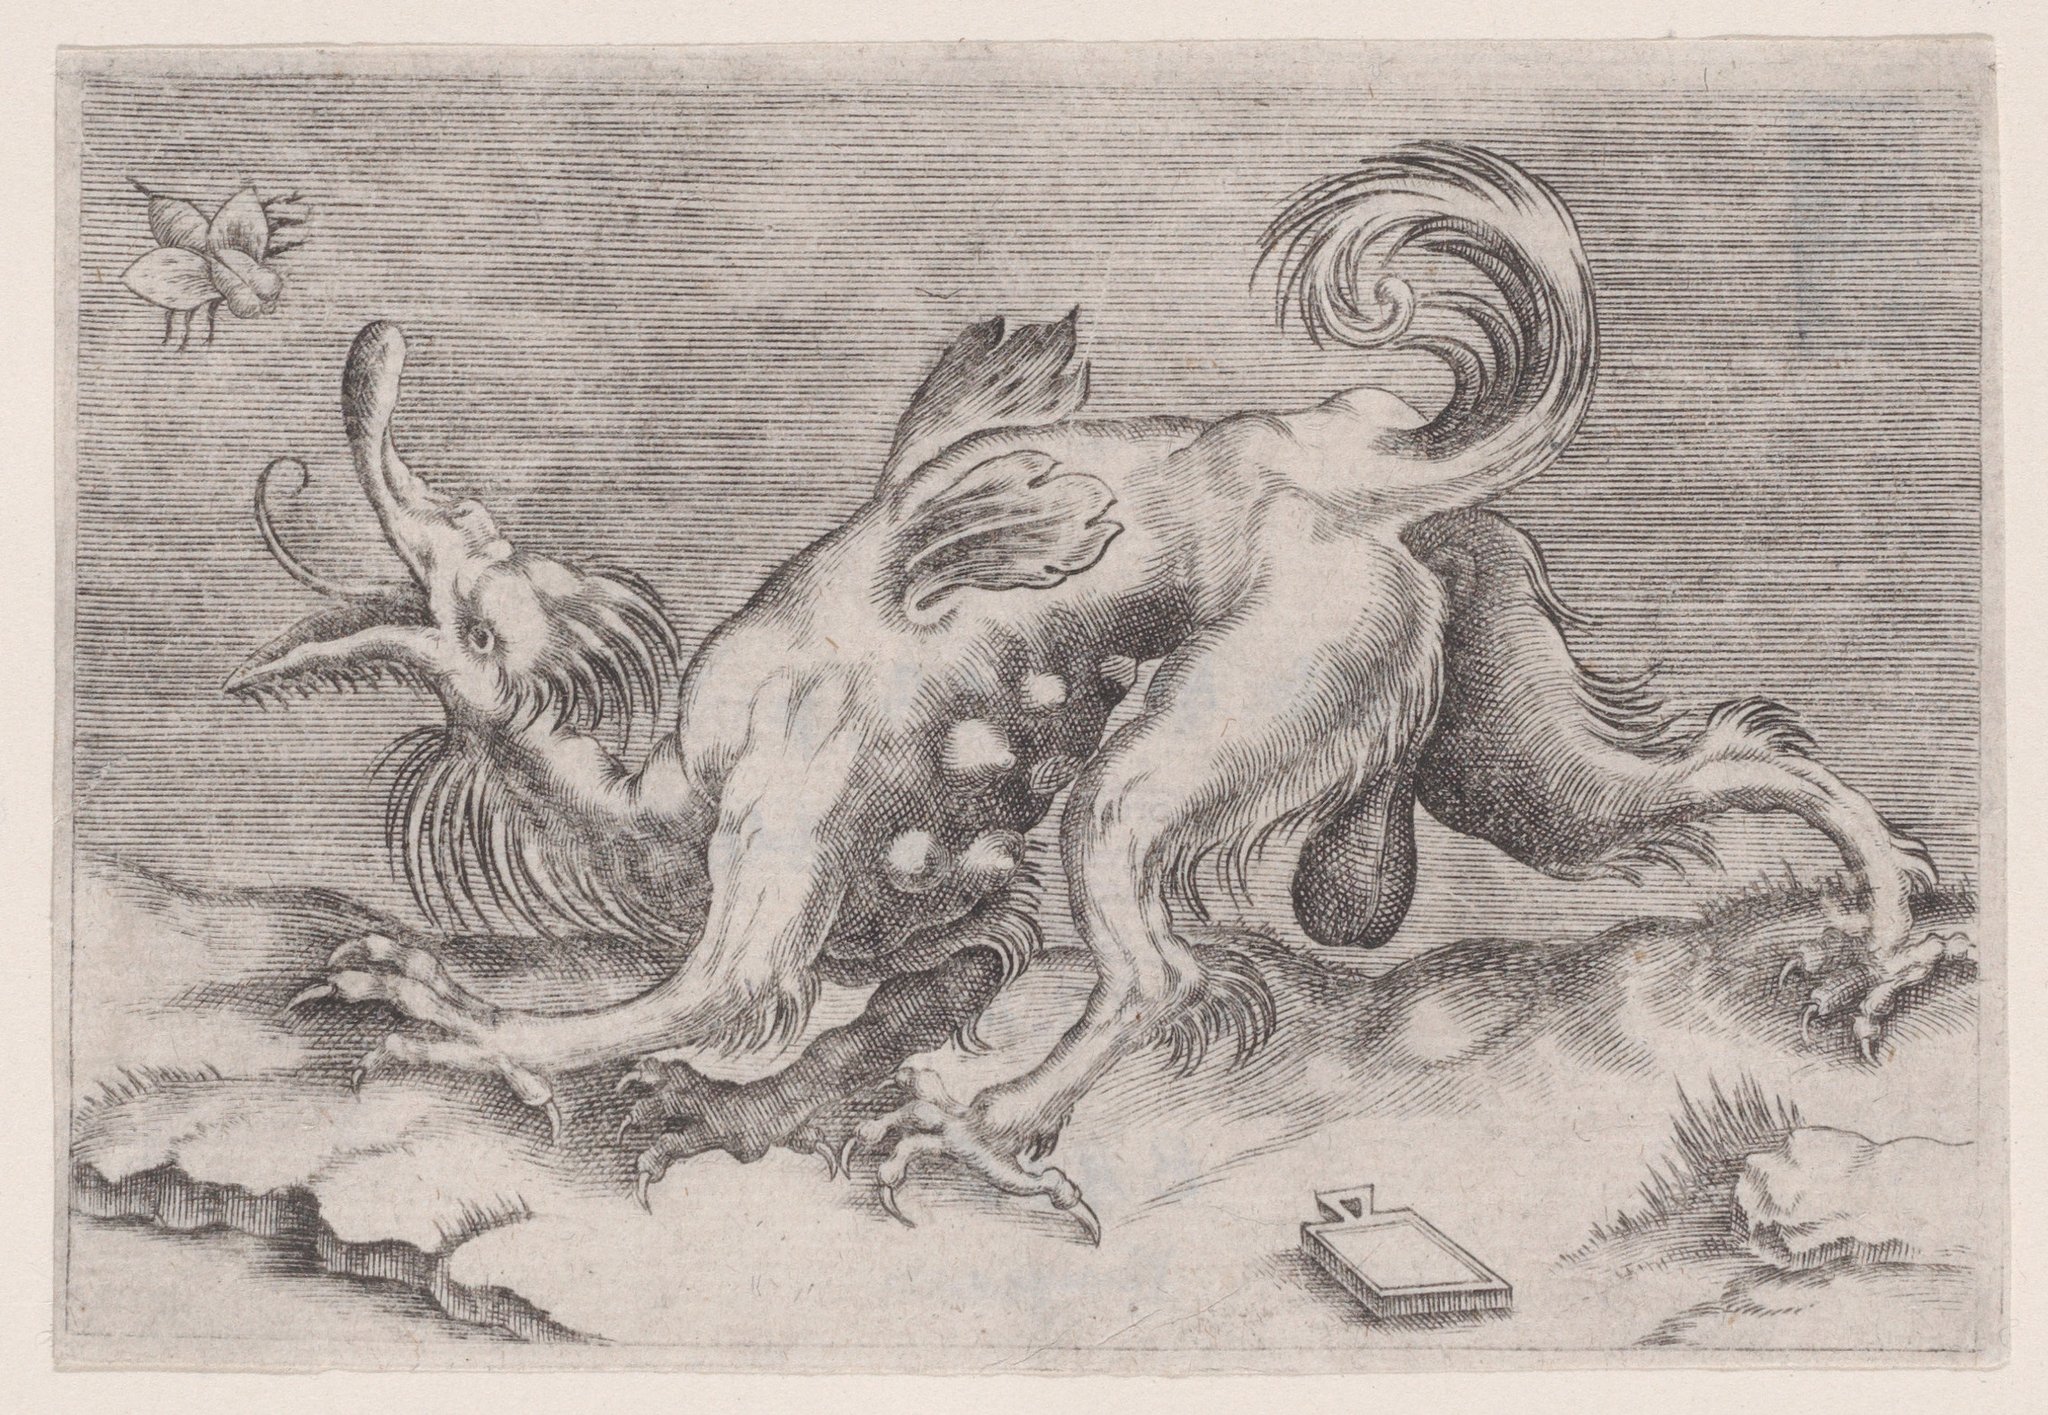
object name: print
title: The Dragon and the Bee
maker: agostino veneziano (agostino dei musi)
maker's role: artist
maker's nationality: italian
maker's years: 1490-1536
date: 1514-1536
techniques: engraving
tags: dragons,bees